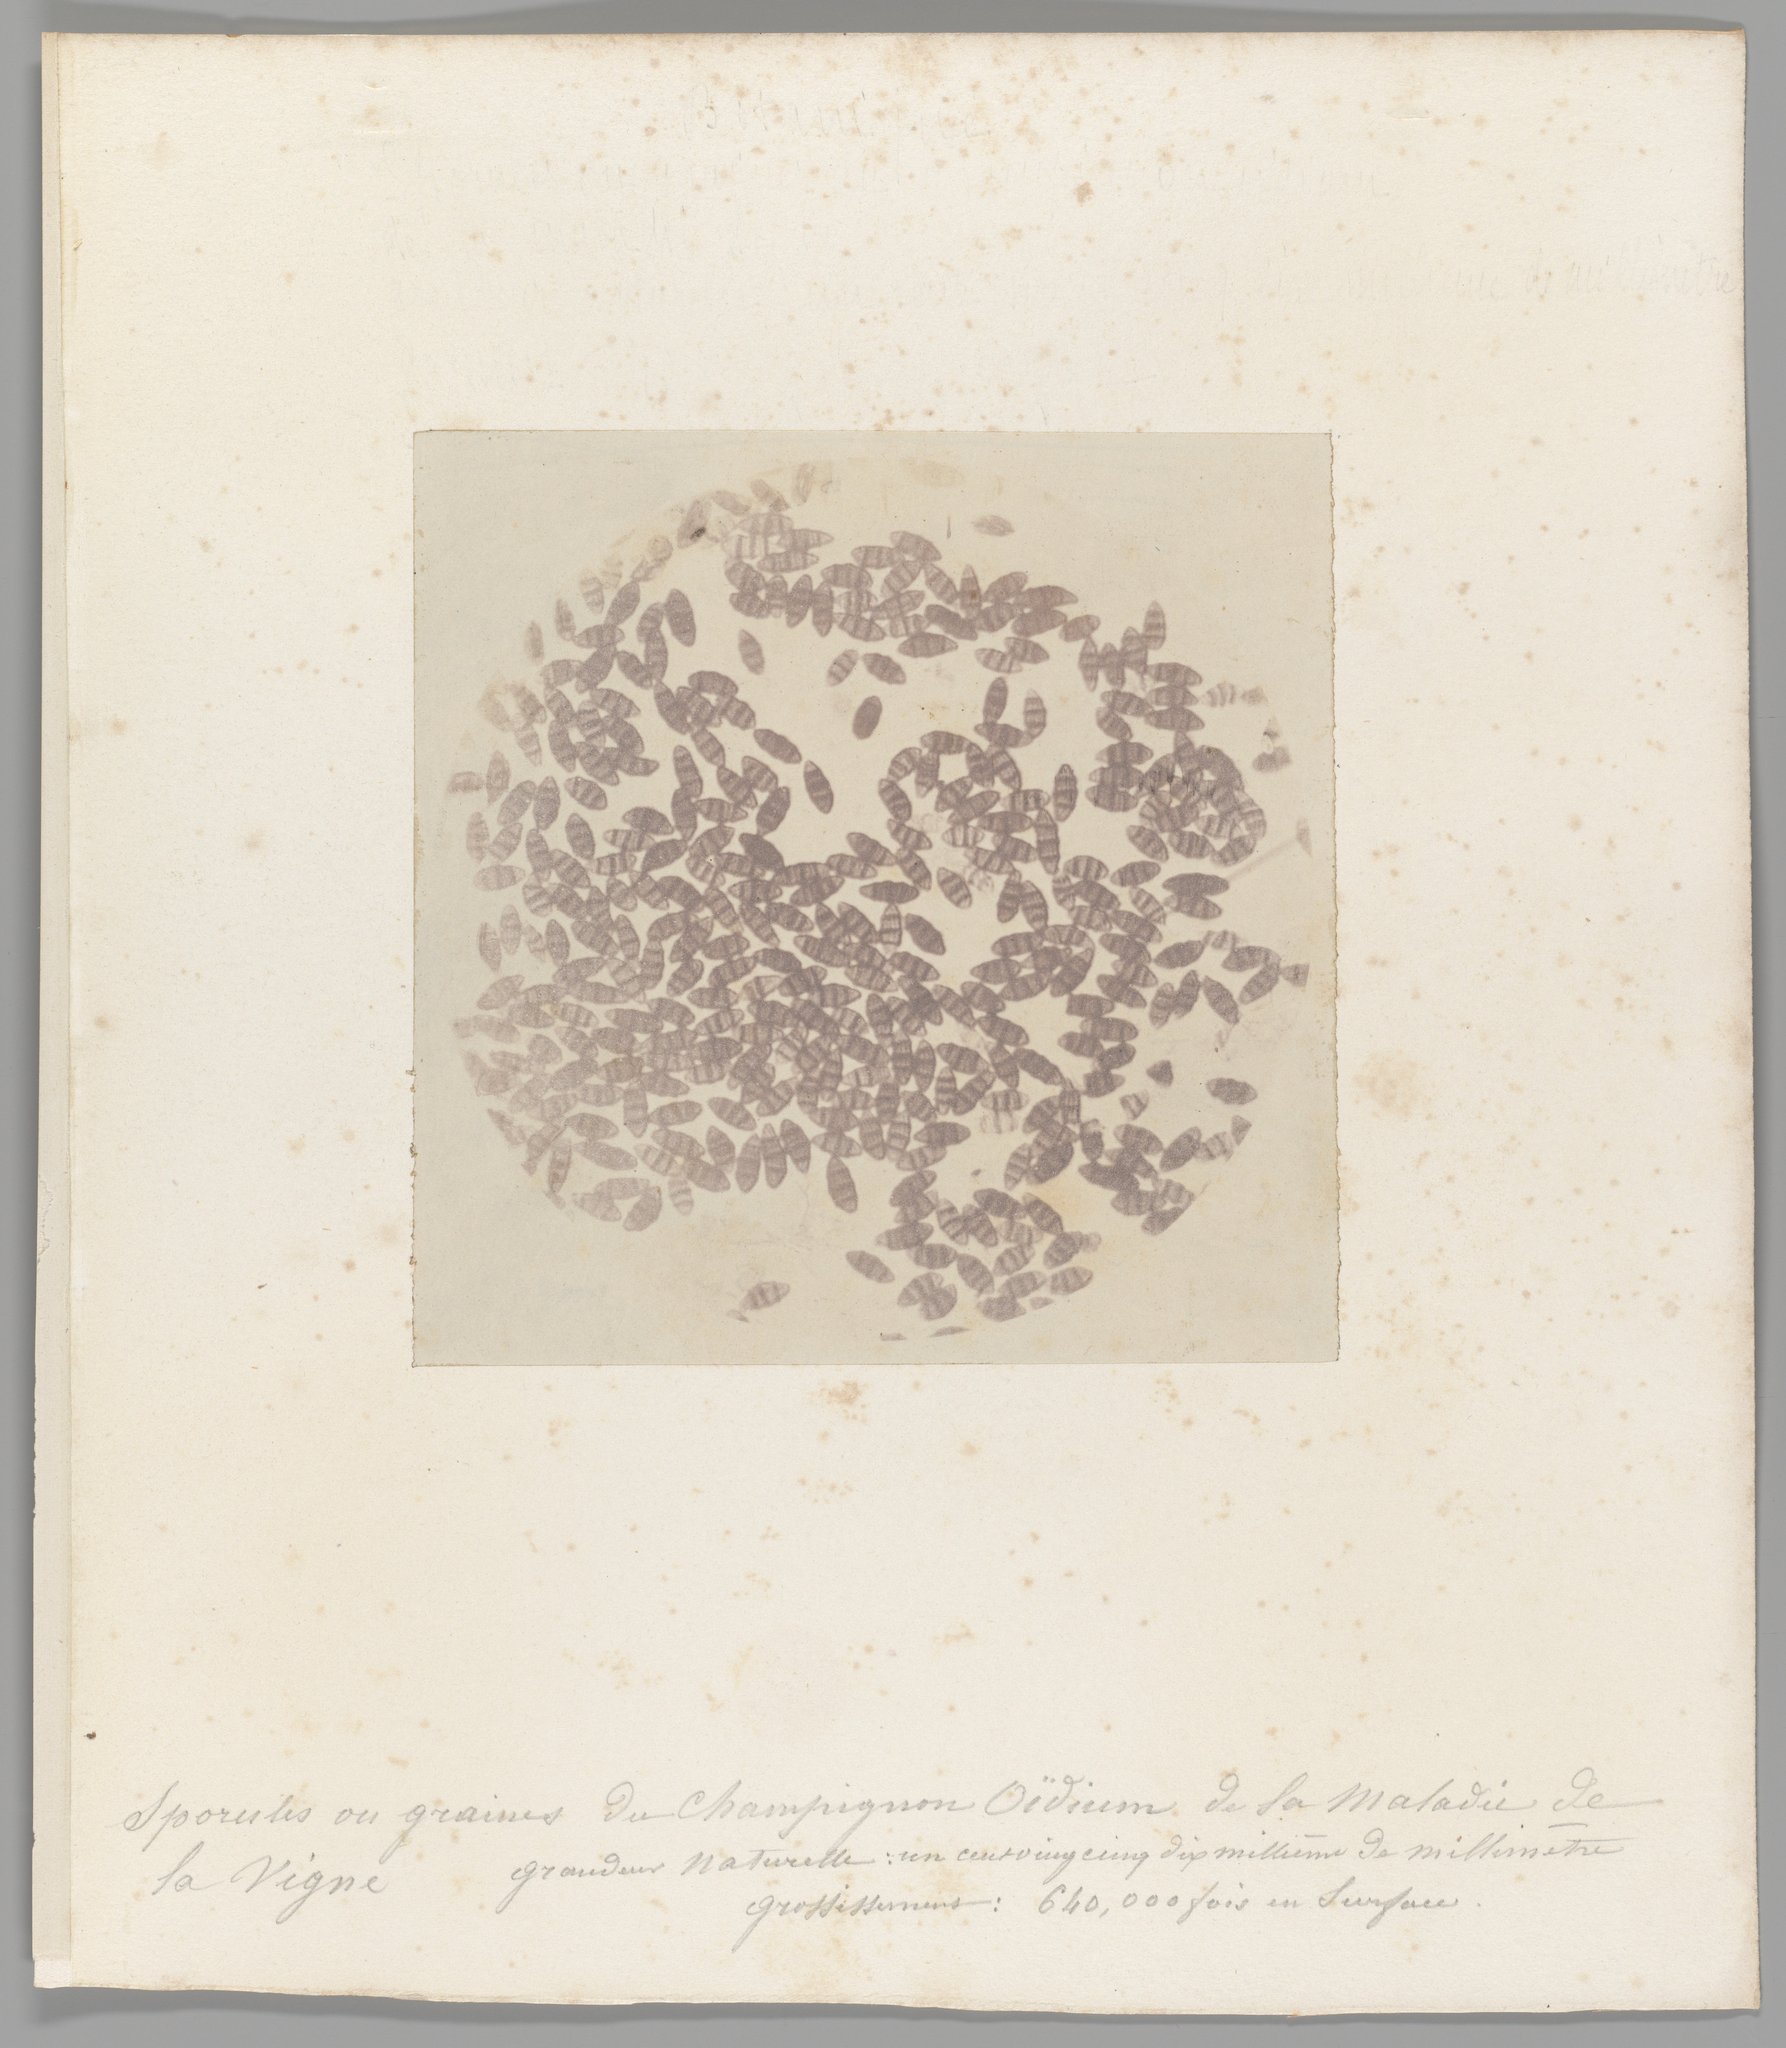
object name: photograph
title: [Untitled]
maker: auguste-adolphe bertsch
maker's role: artist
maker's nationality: french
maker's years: 1813-1871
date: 1853-1857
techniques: salted paper print